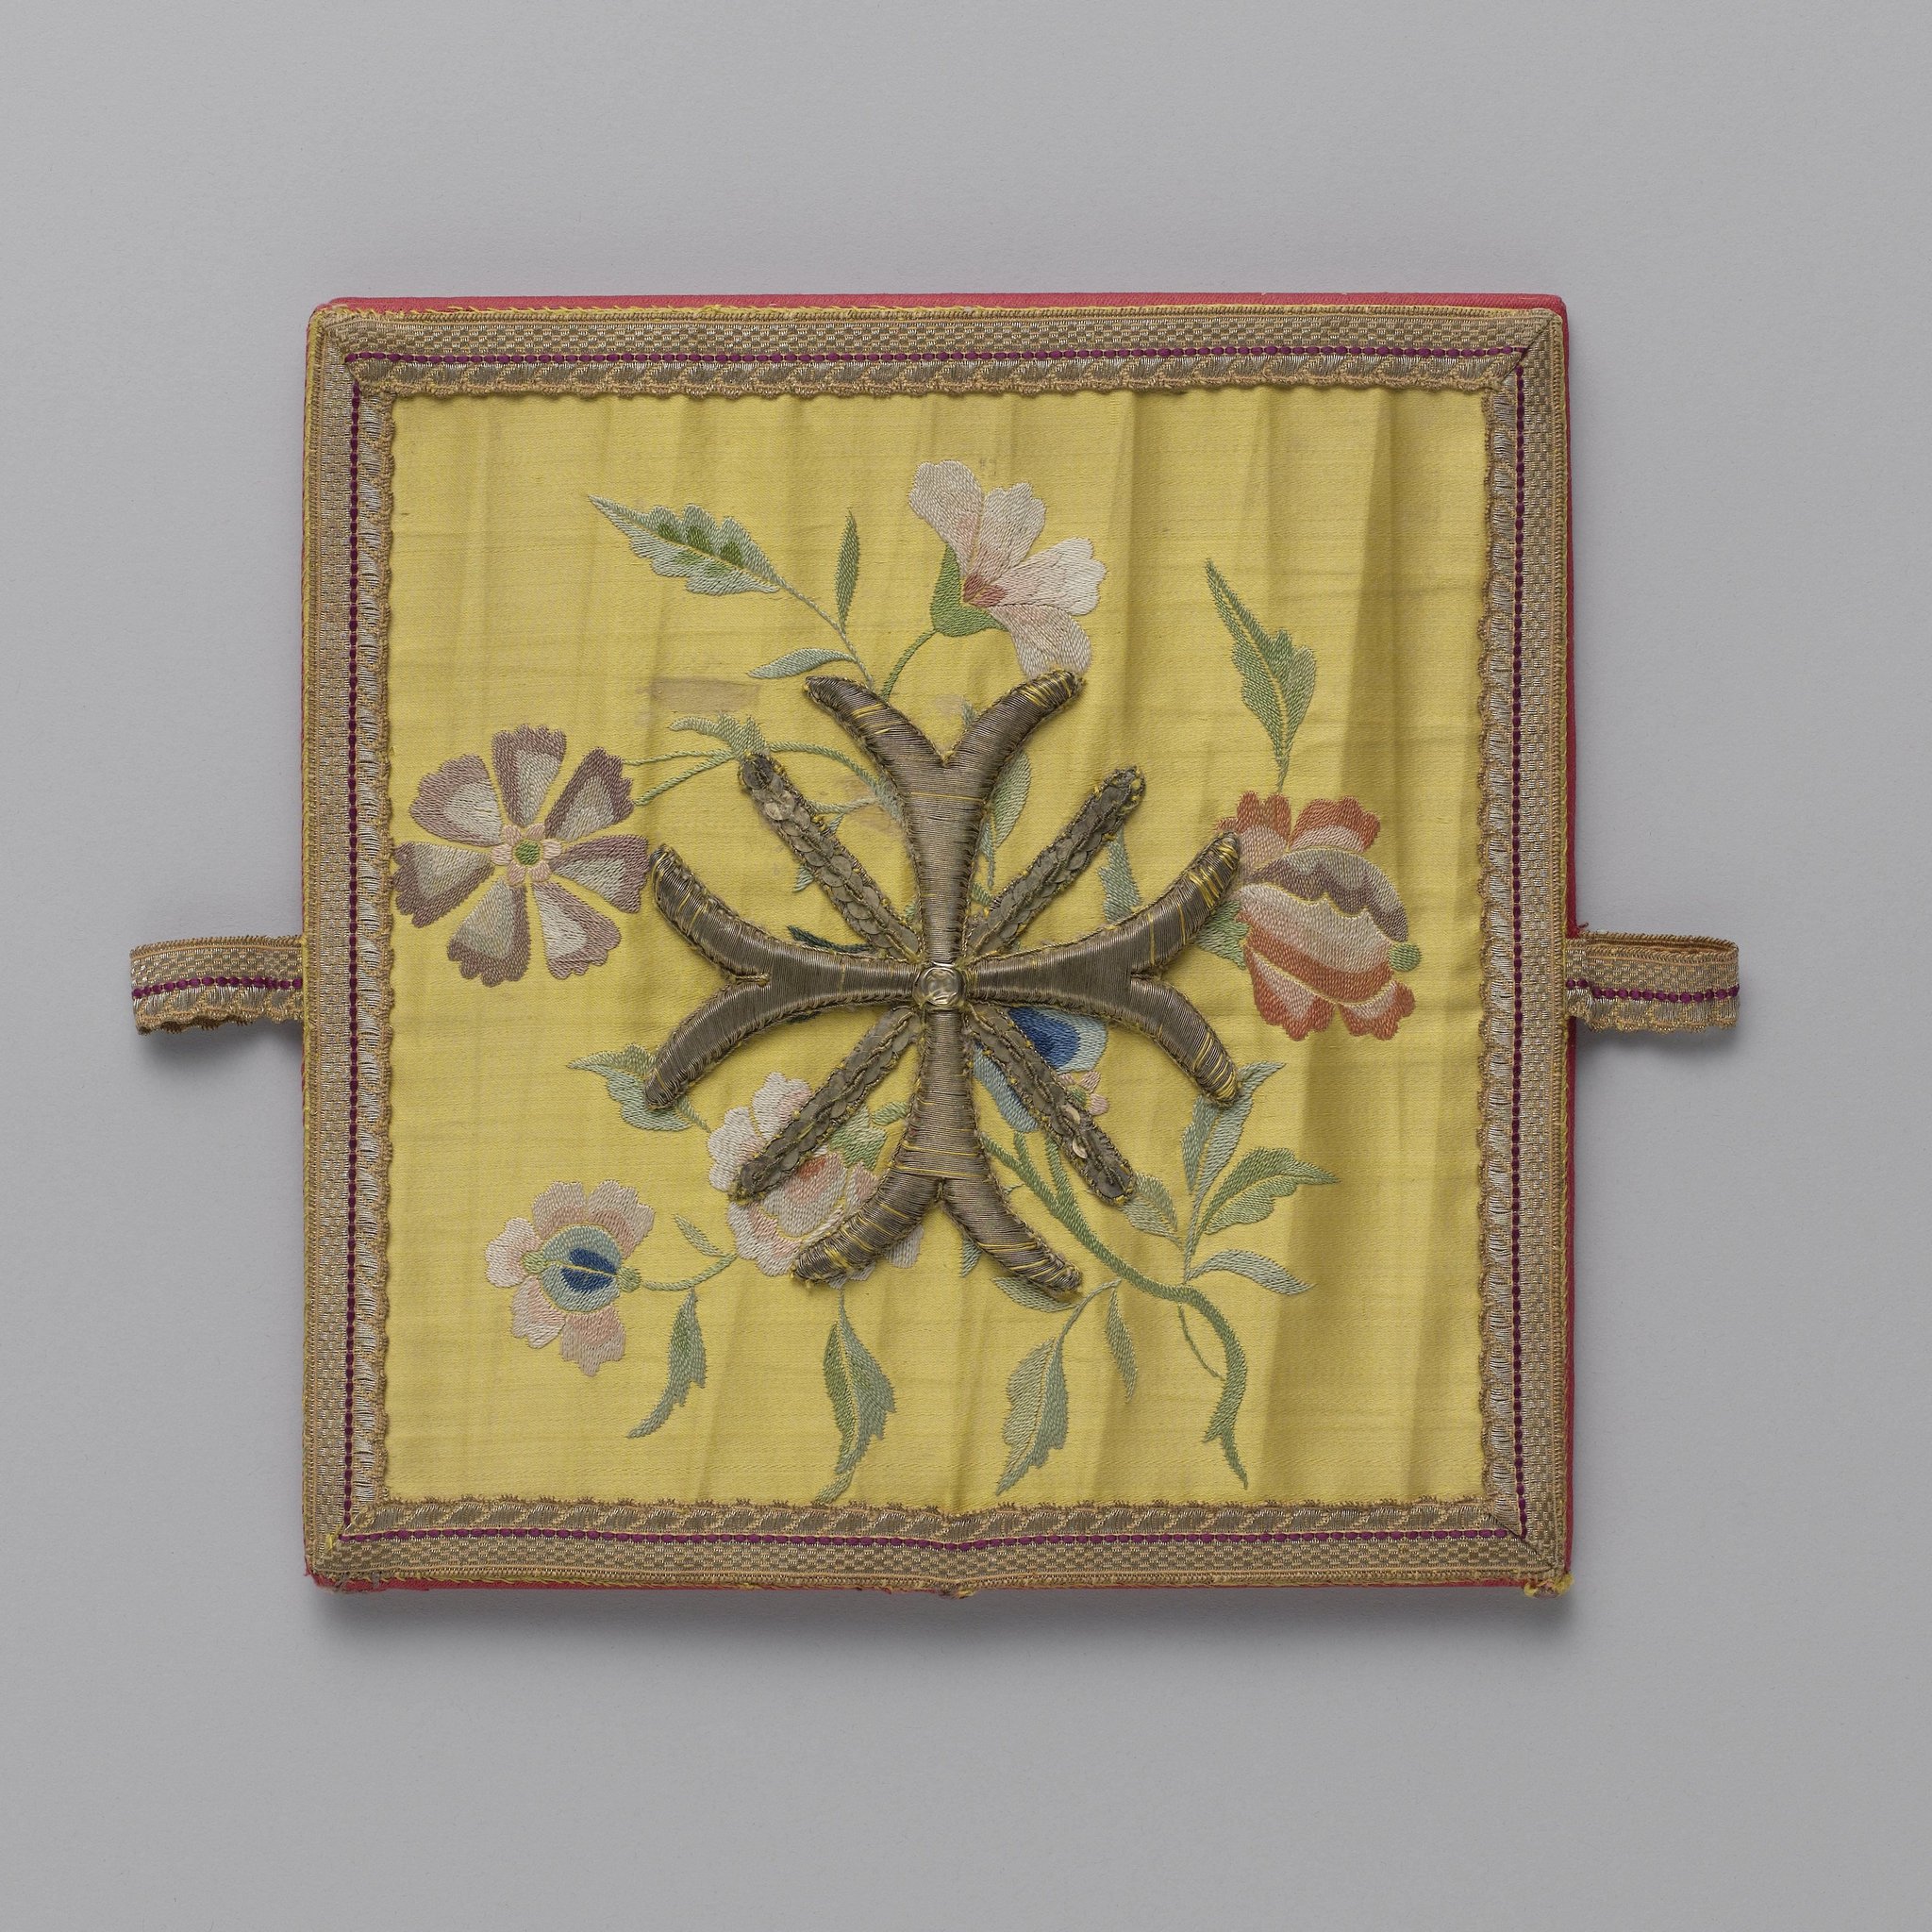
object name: burse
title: Bursa van geel zijdesatijn met borduurwerk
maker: Anonymous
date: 1750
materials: gold thread, silk, thread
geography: china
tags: st. franciscus xaveriusparochie ''t zand'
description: Bursa van geel zijdesatijn met borduurwerk in zijde en in hoogreliëf met goud- en zilverdraad met voorstelling van Grieks kruis. Bursa maakt onderdeel uit van een stel (BK-2008-176-A t/m E).